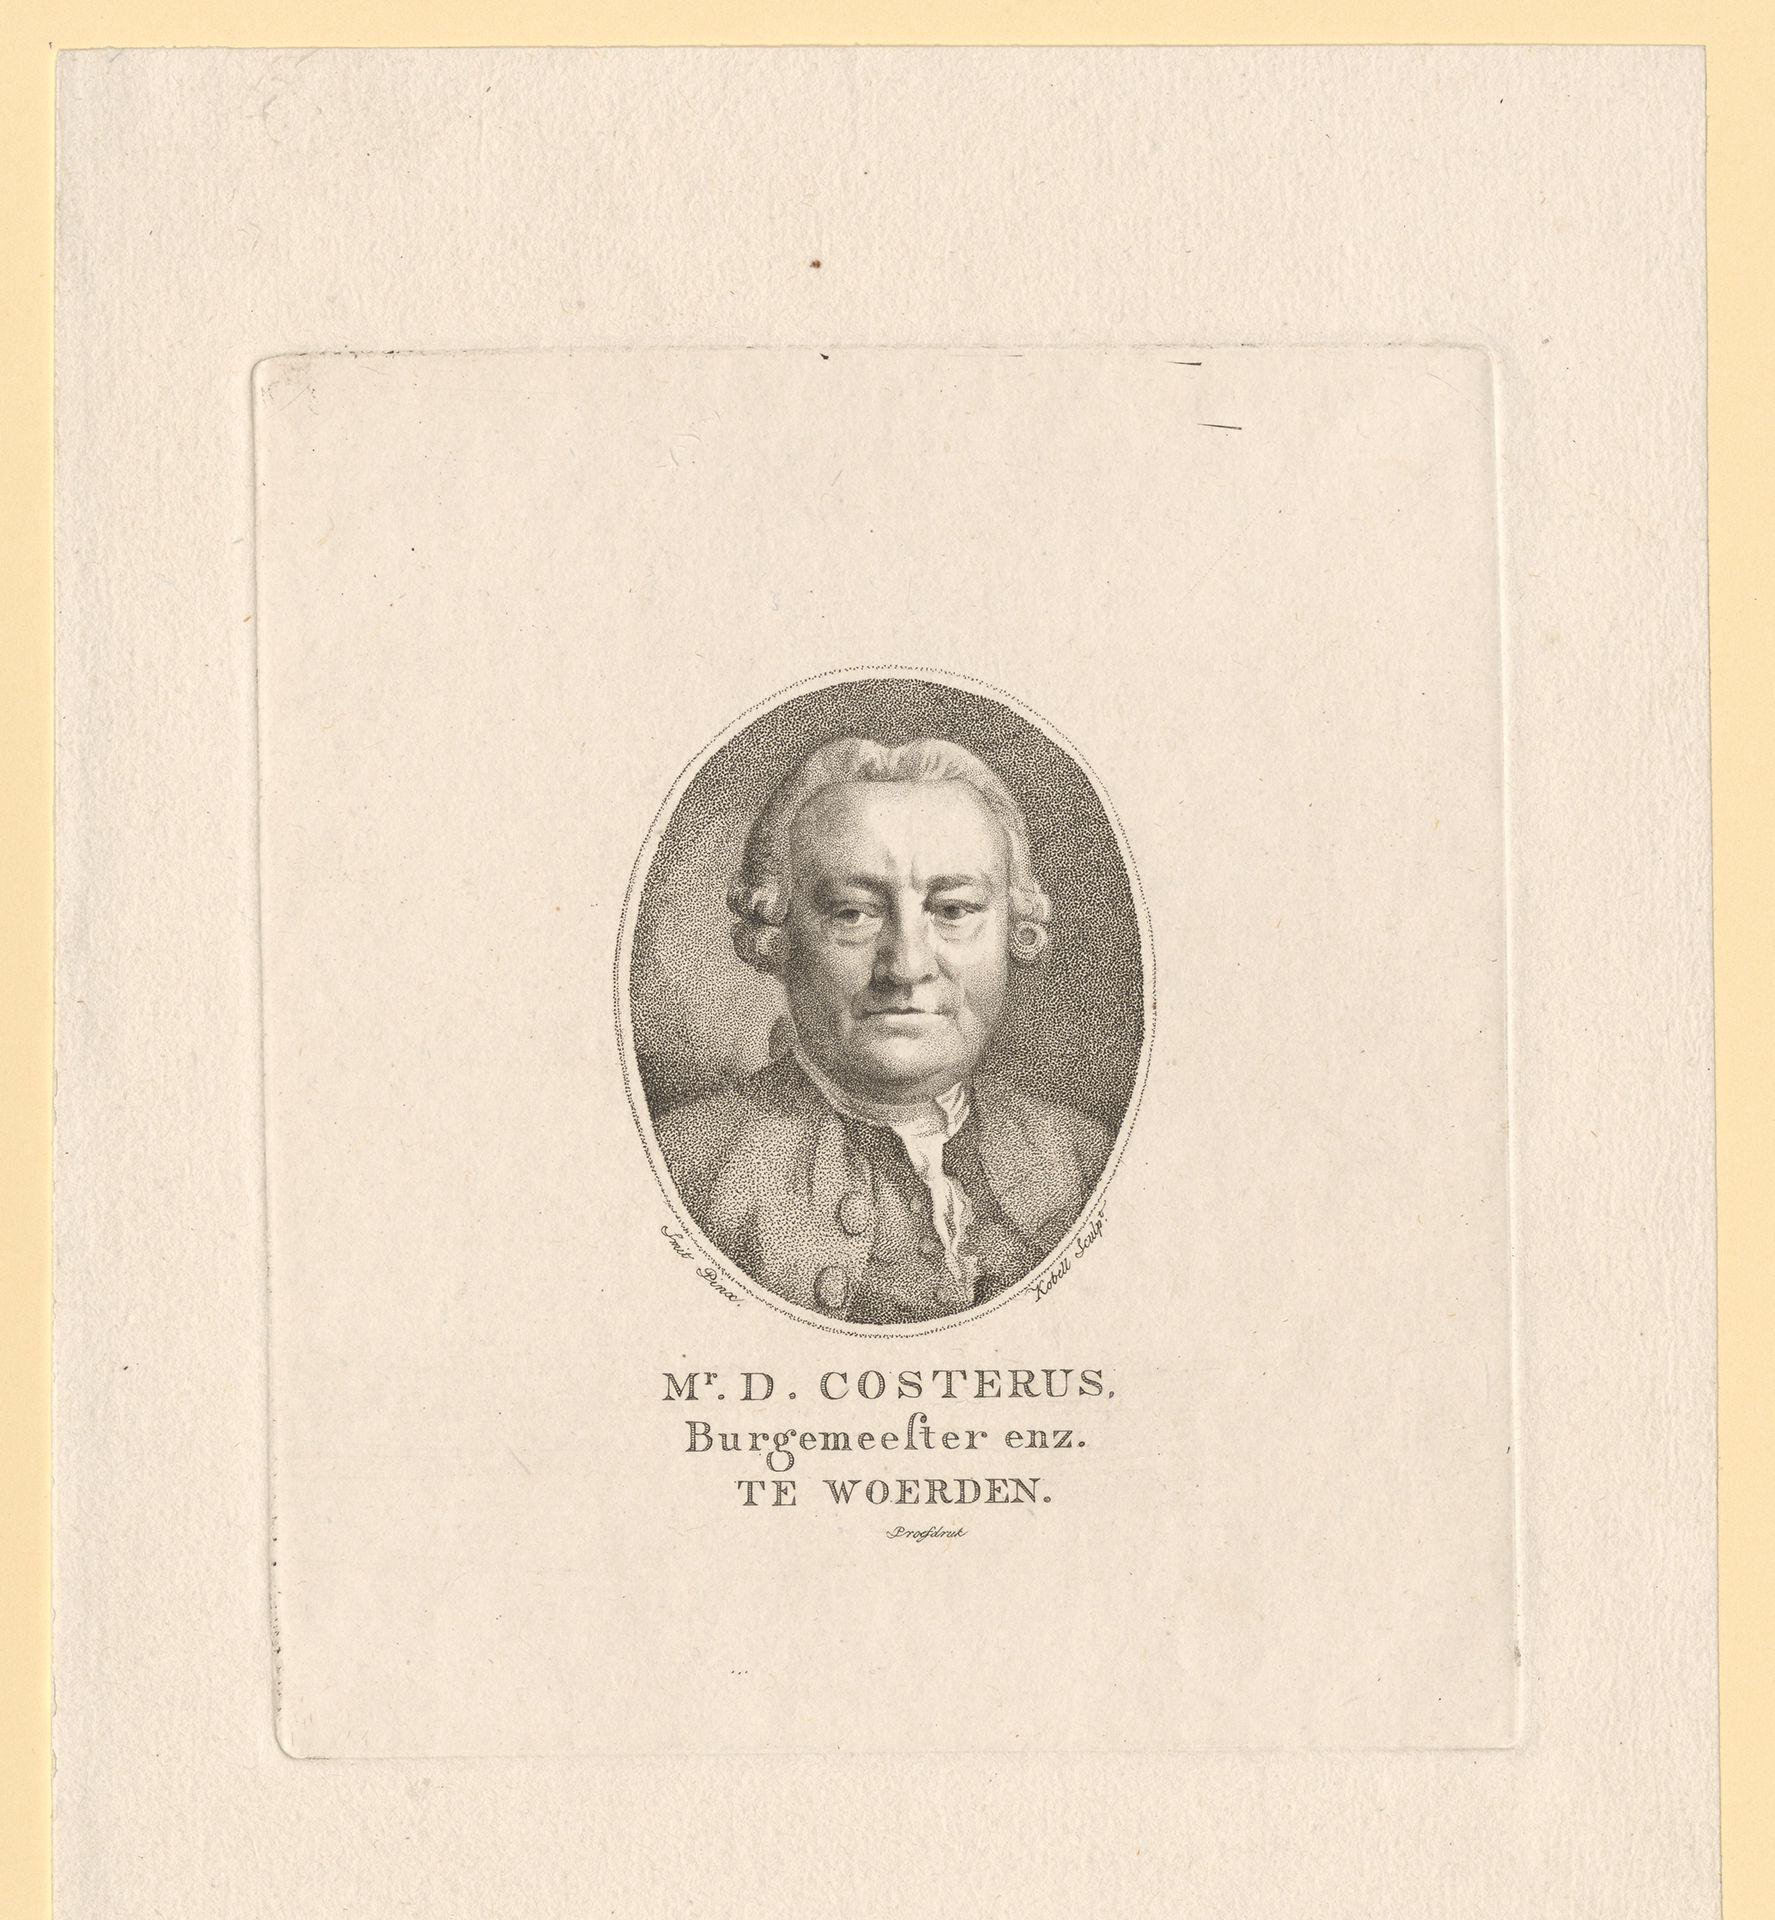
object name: print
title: Portret van Dominicus Costerus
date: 1787-1833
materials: paper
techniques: engraving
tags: historical persons